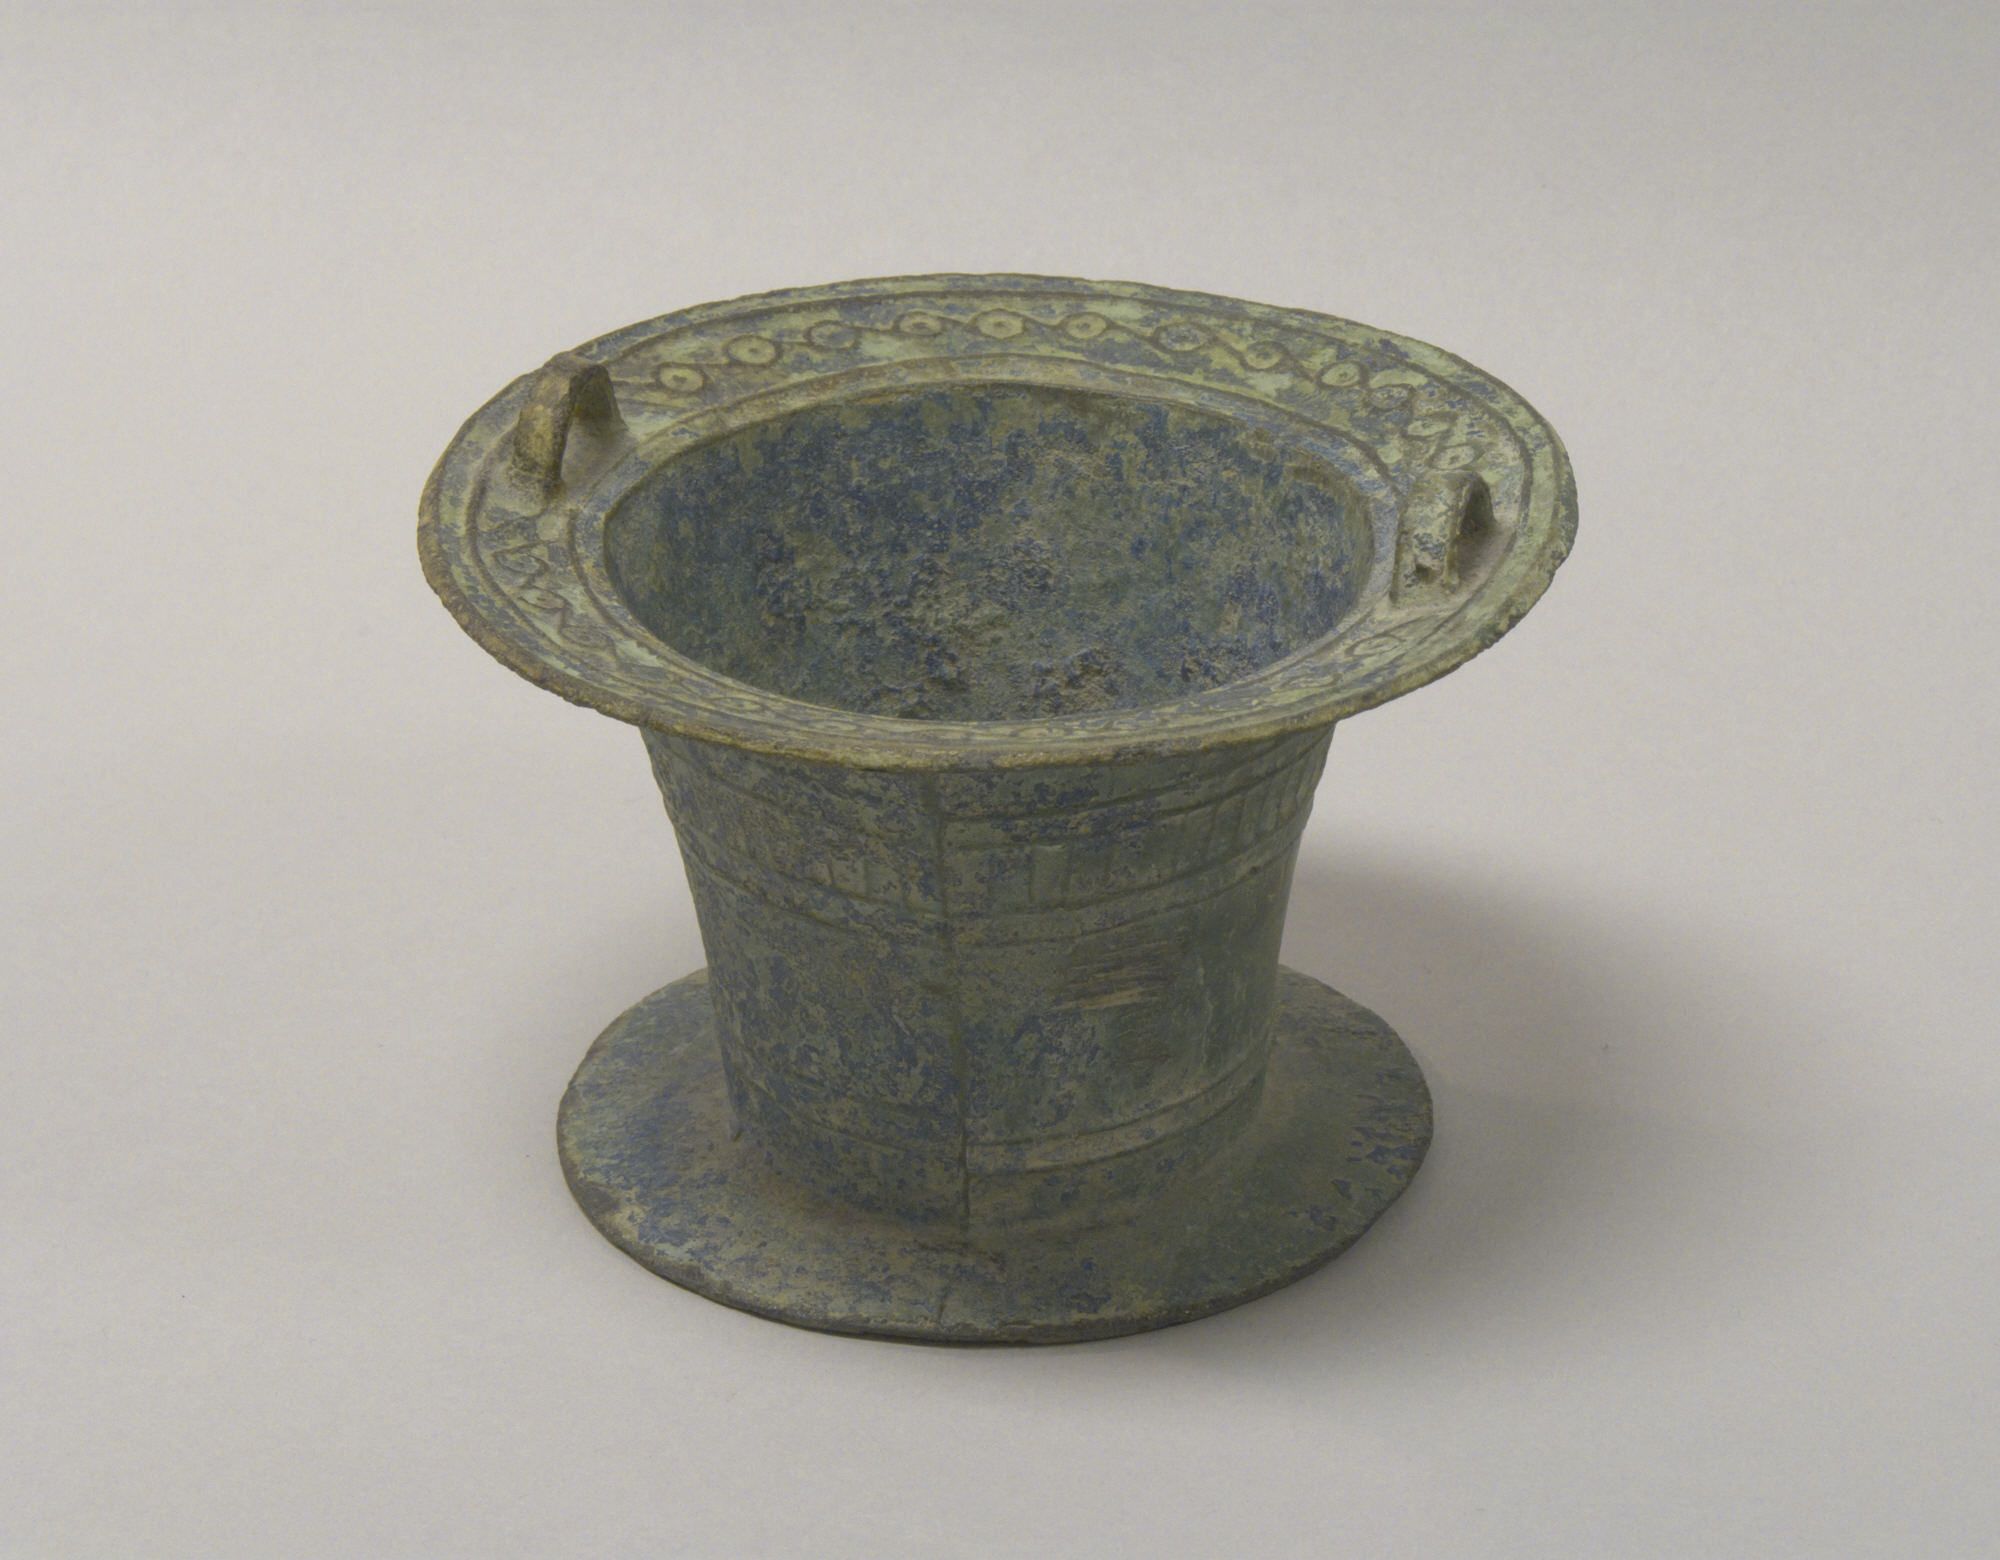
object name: cauldron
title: Miniature Cauldron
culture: vietnamese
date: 500 BCE-300 CE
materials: bronze